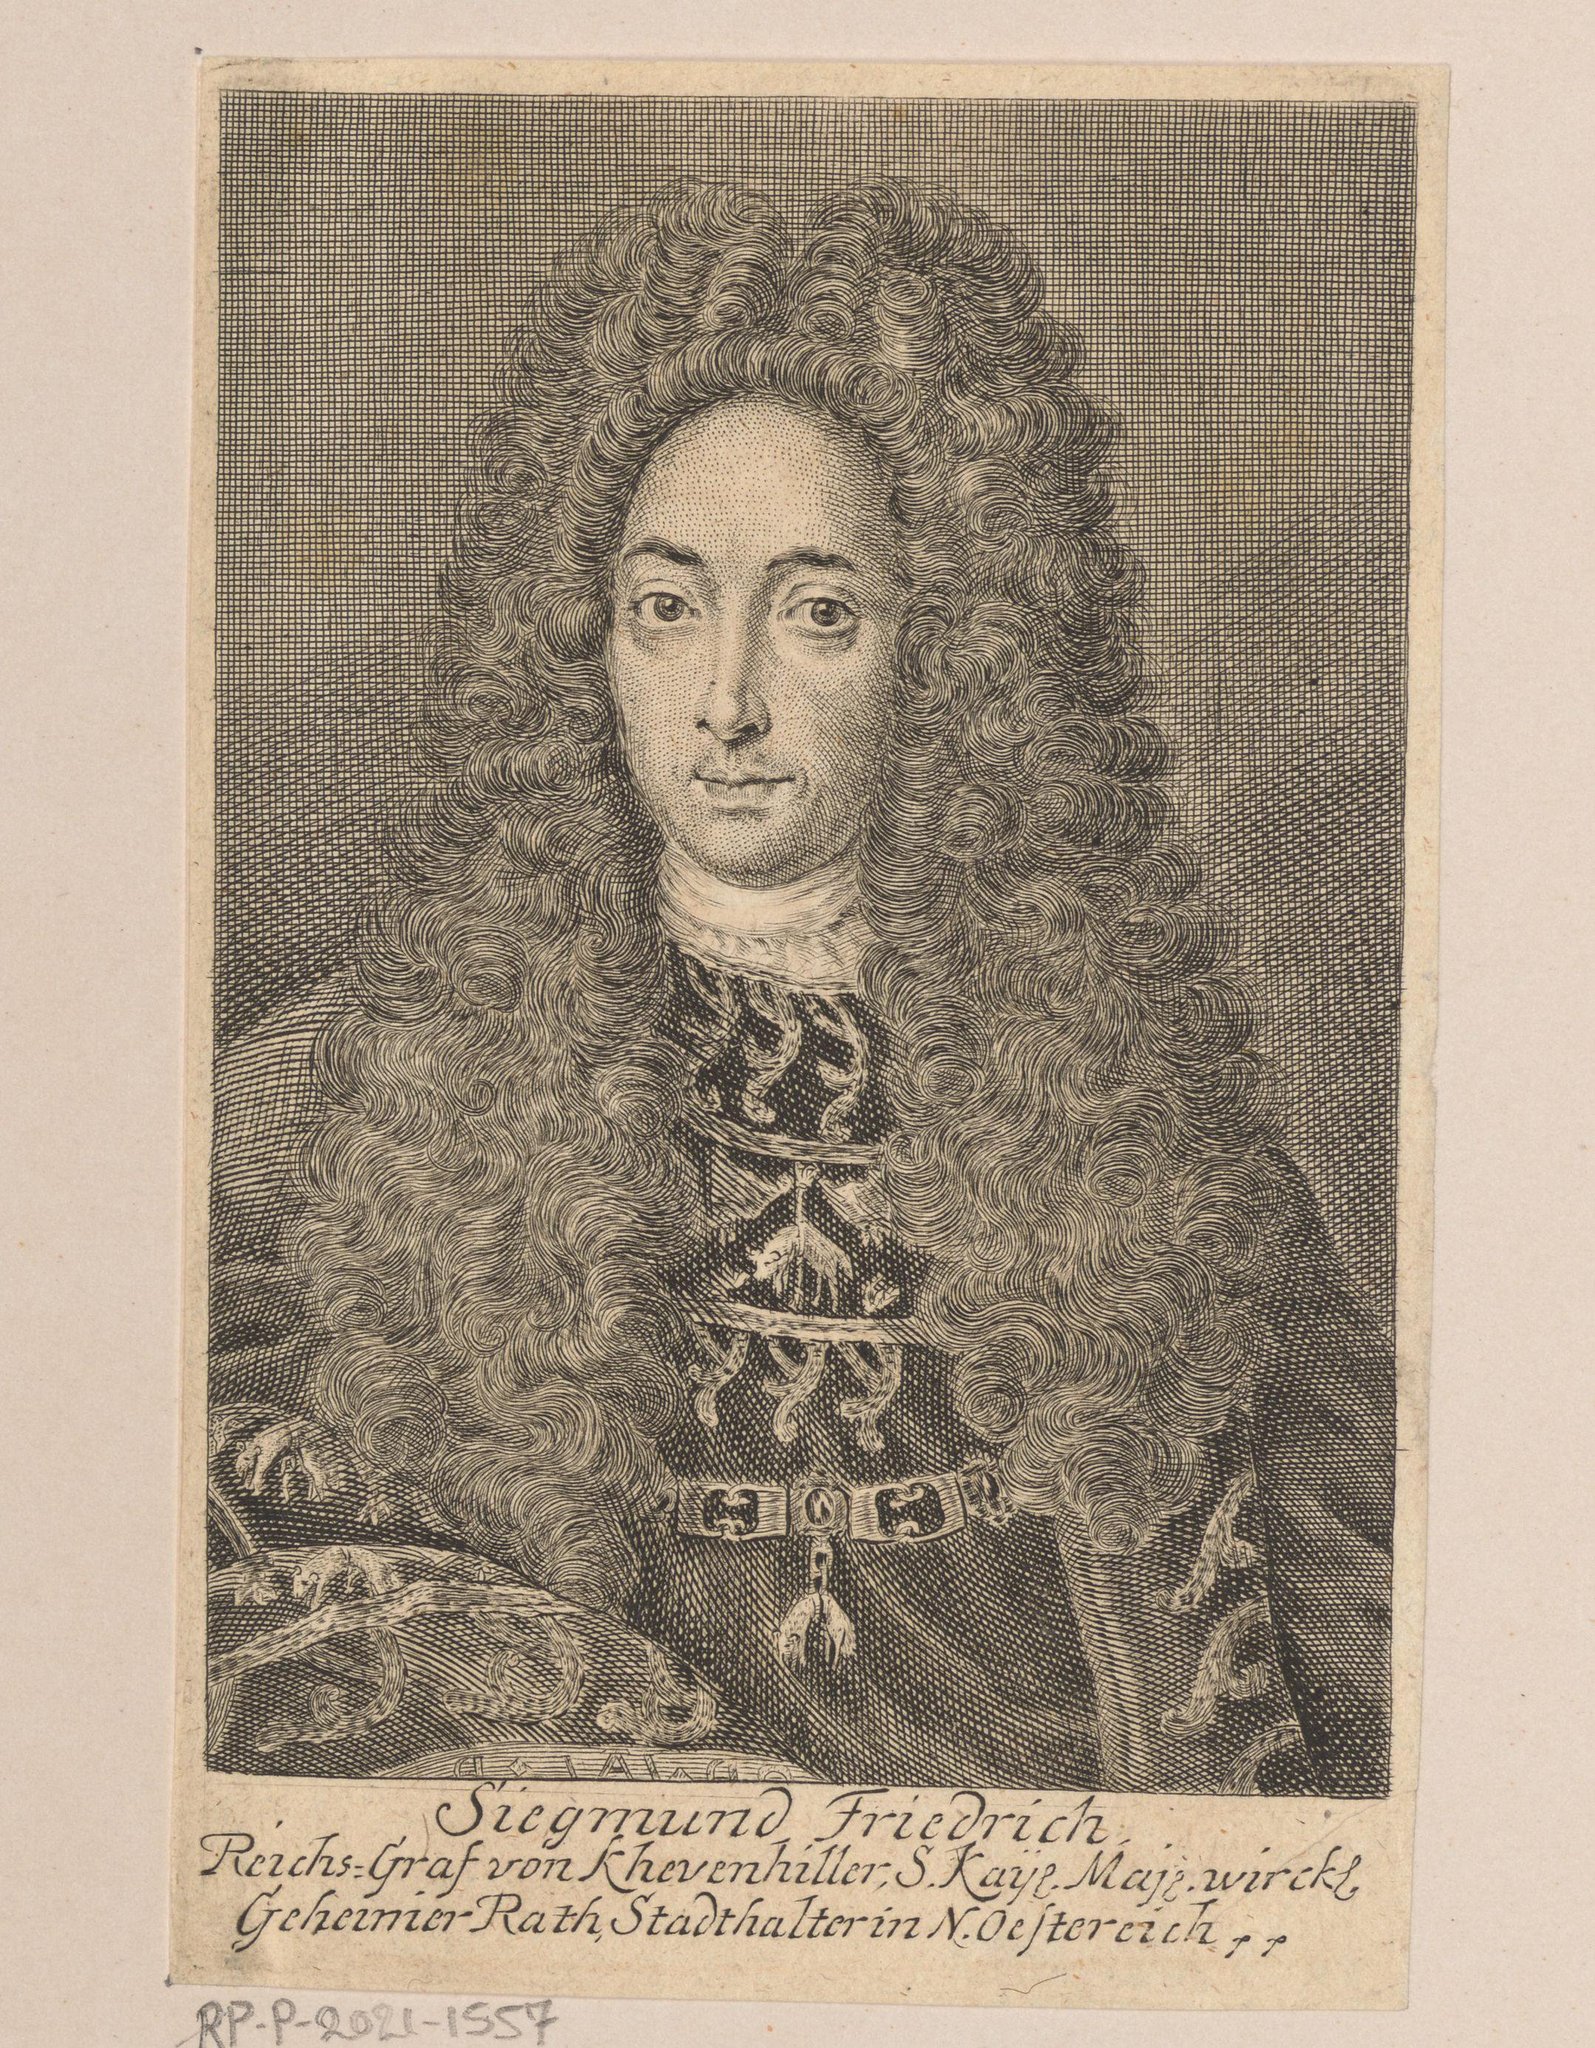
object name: print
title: Portret van Sigismund Friedrich Khevenhüller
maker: martin bernigeroth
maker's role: print maker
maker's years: 1670-1733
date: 1723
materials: paper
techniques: engraving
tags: historical persons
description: Prent mogelijk uit: Die Europäische Fama, Welche den gegenwärtigen Zustand der vornehmsten Höfe entdecket. Keulen: s.n., 1723, dl. 267.